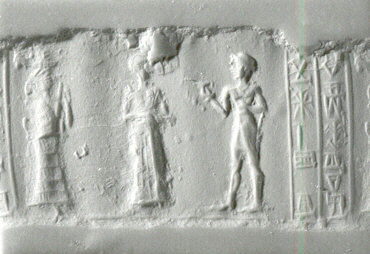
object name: cylinder seal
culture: babylonian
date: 1900-1601 BCE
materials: stone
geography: mesopotamia